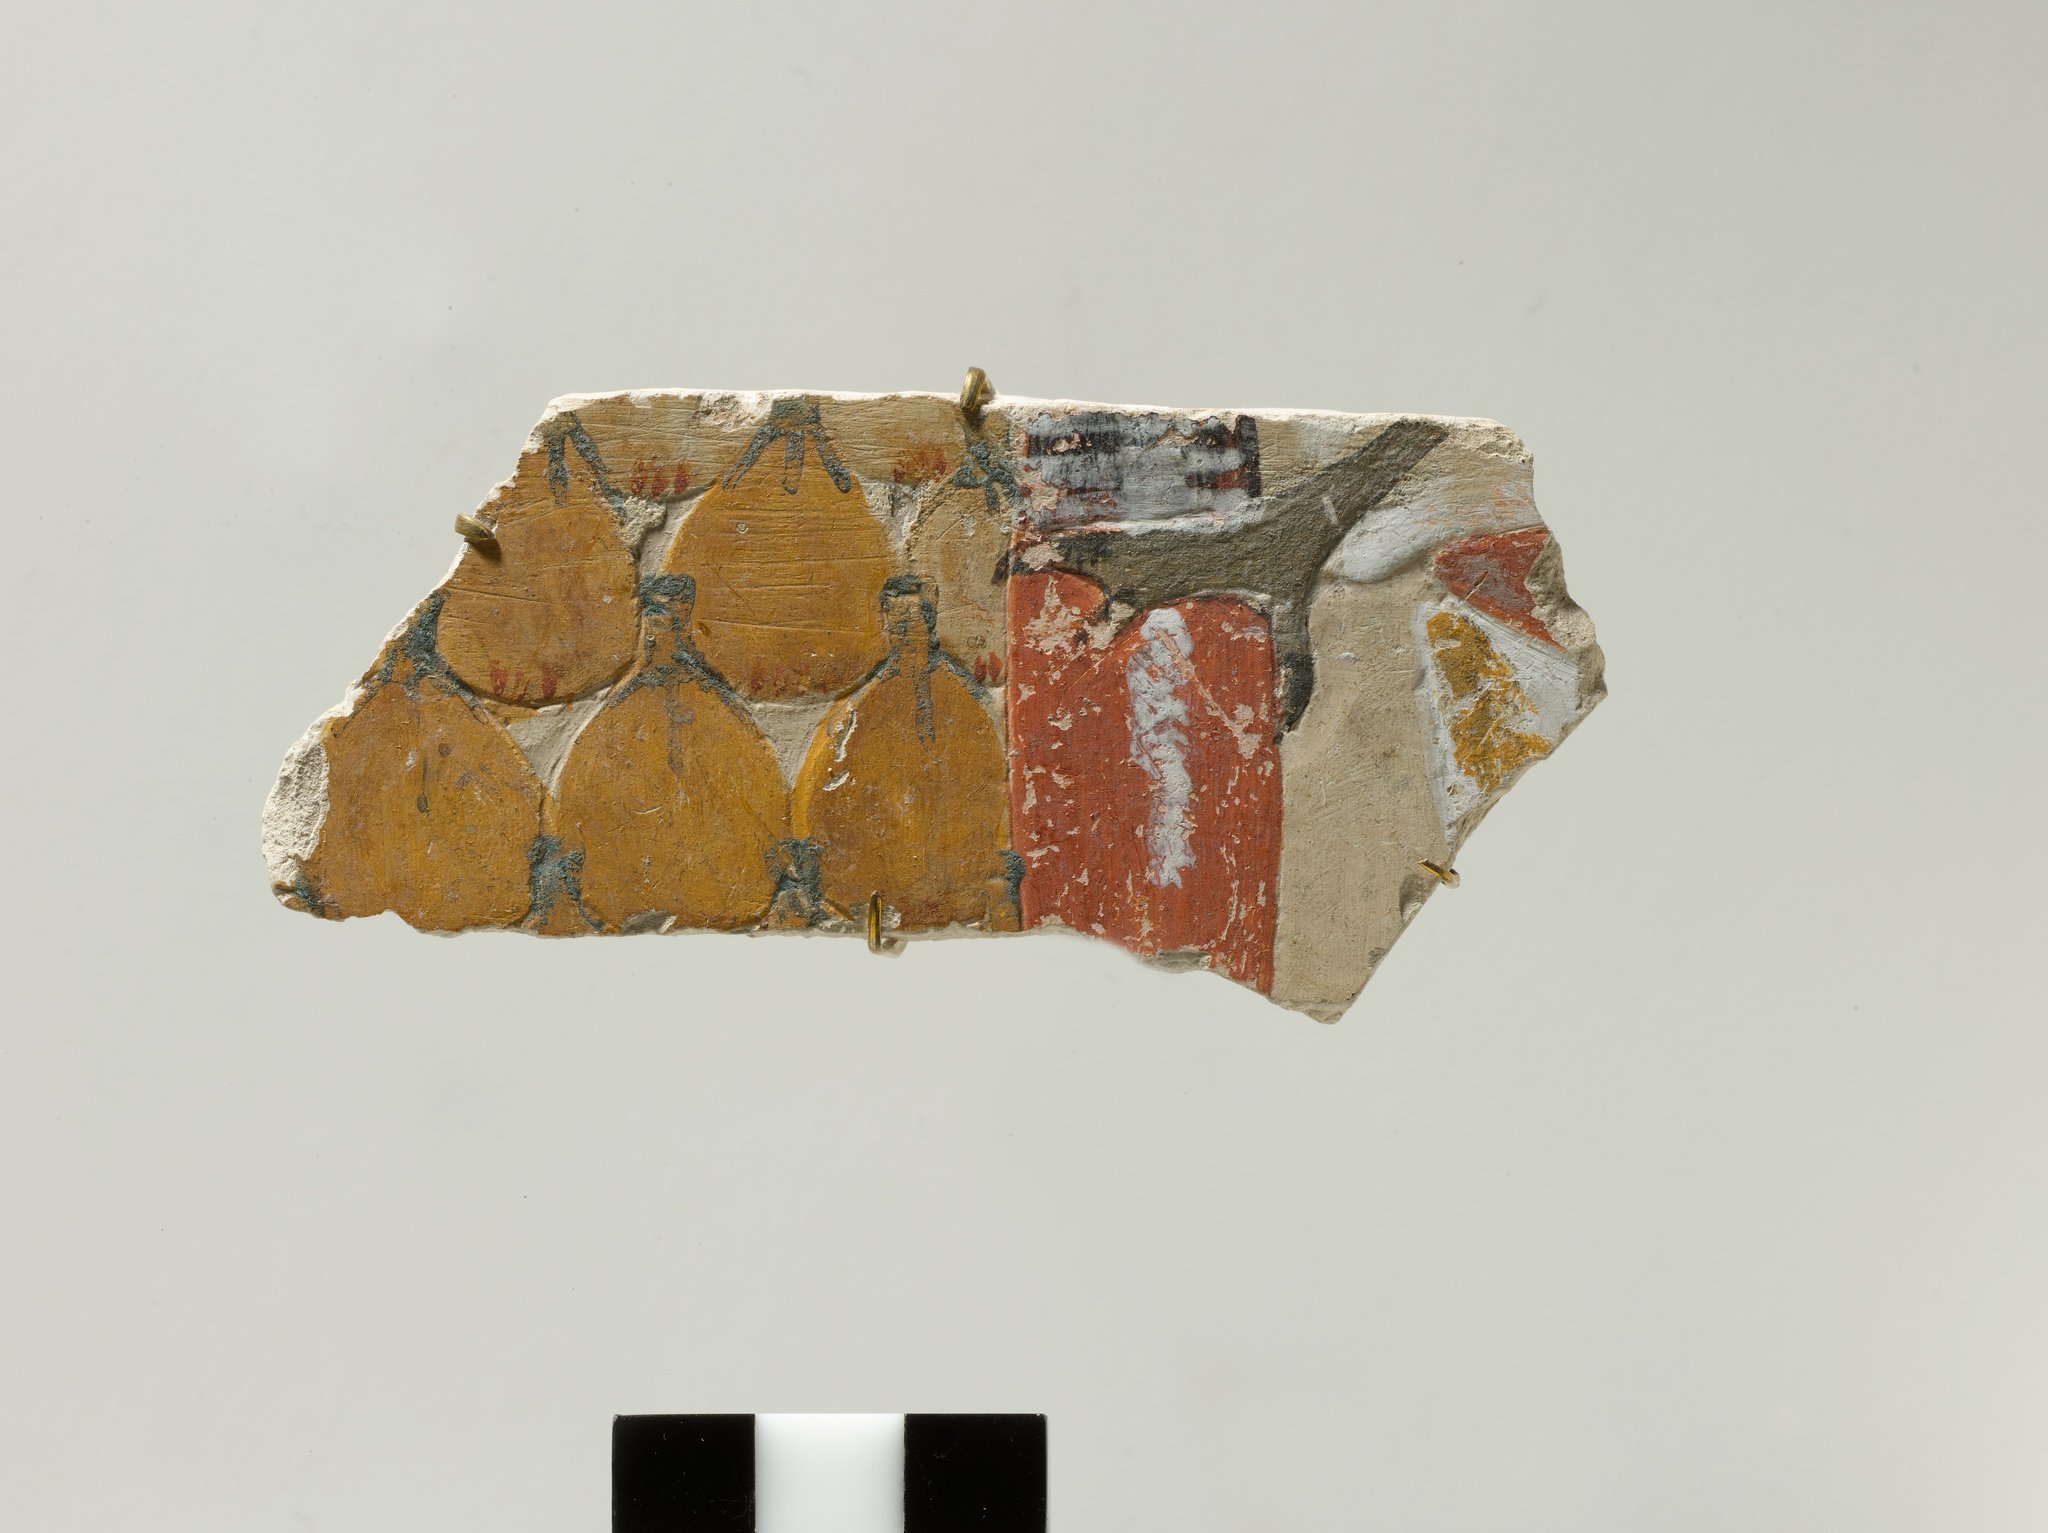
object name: relief fragment, tomb of meketre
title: Relief fragment from the tomb of Meketre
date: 1981-1975 BCE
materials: limestone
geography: egypt